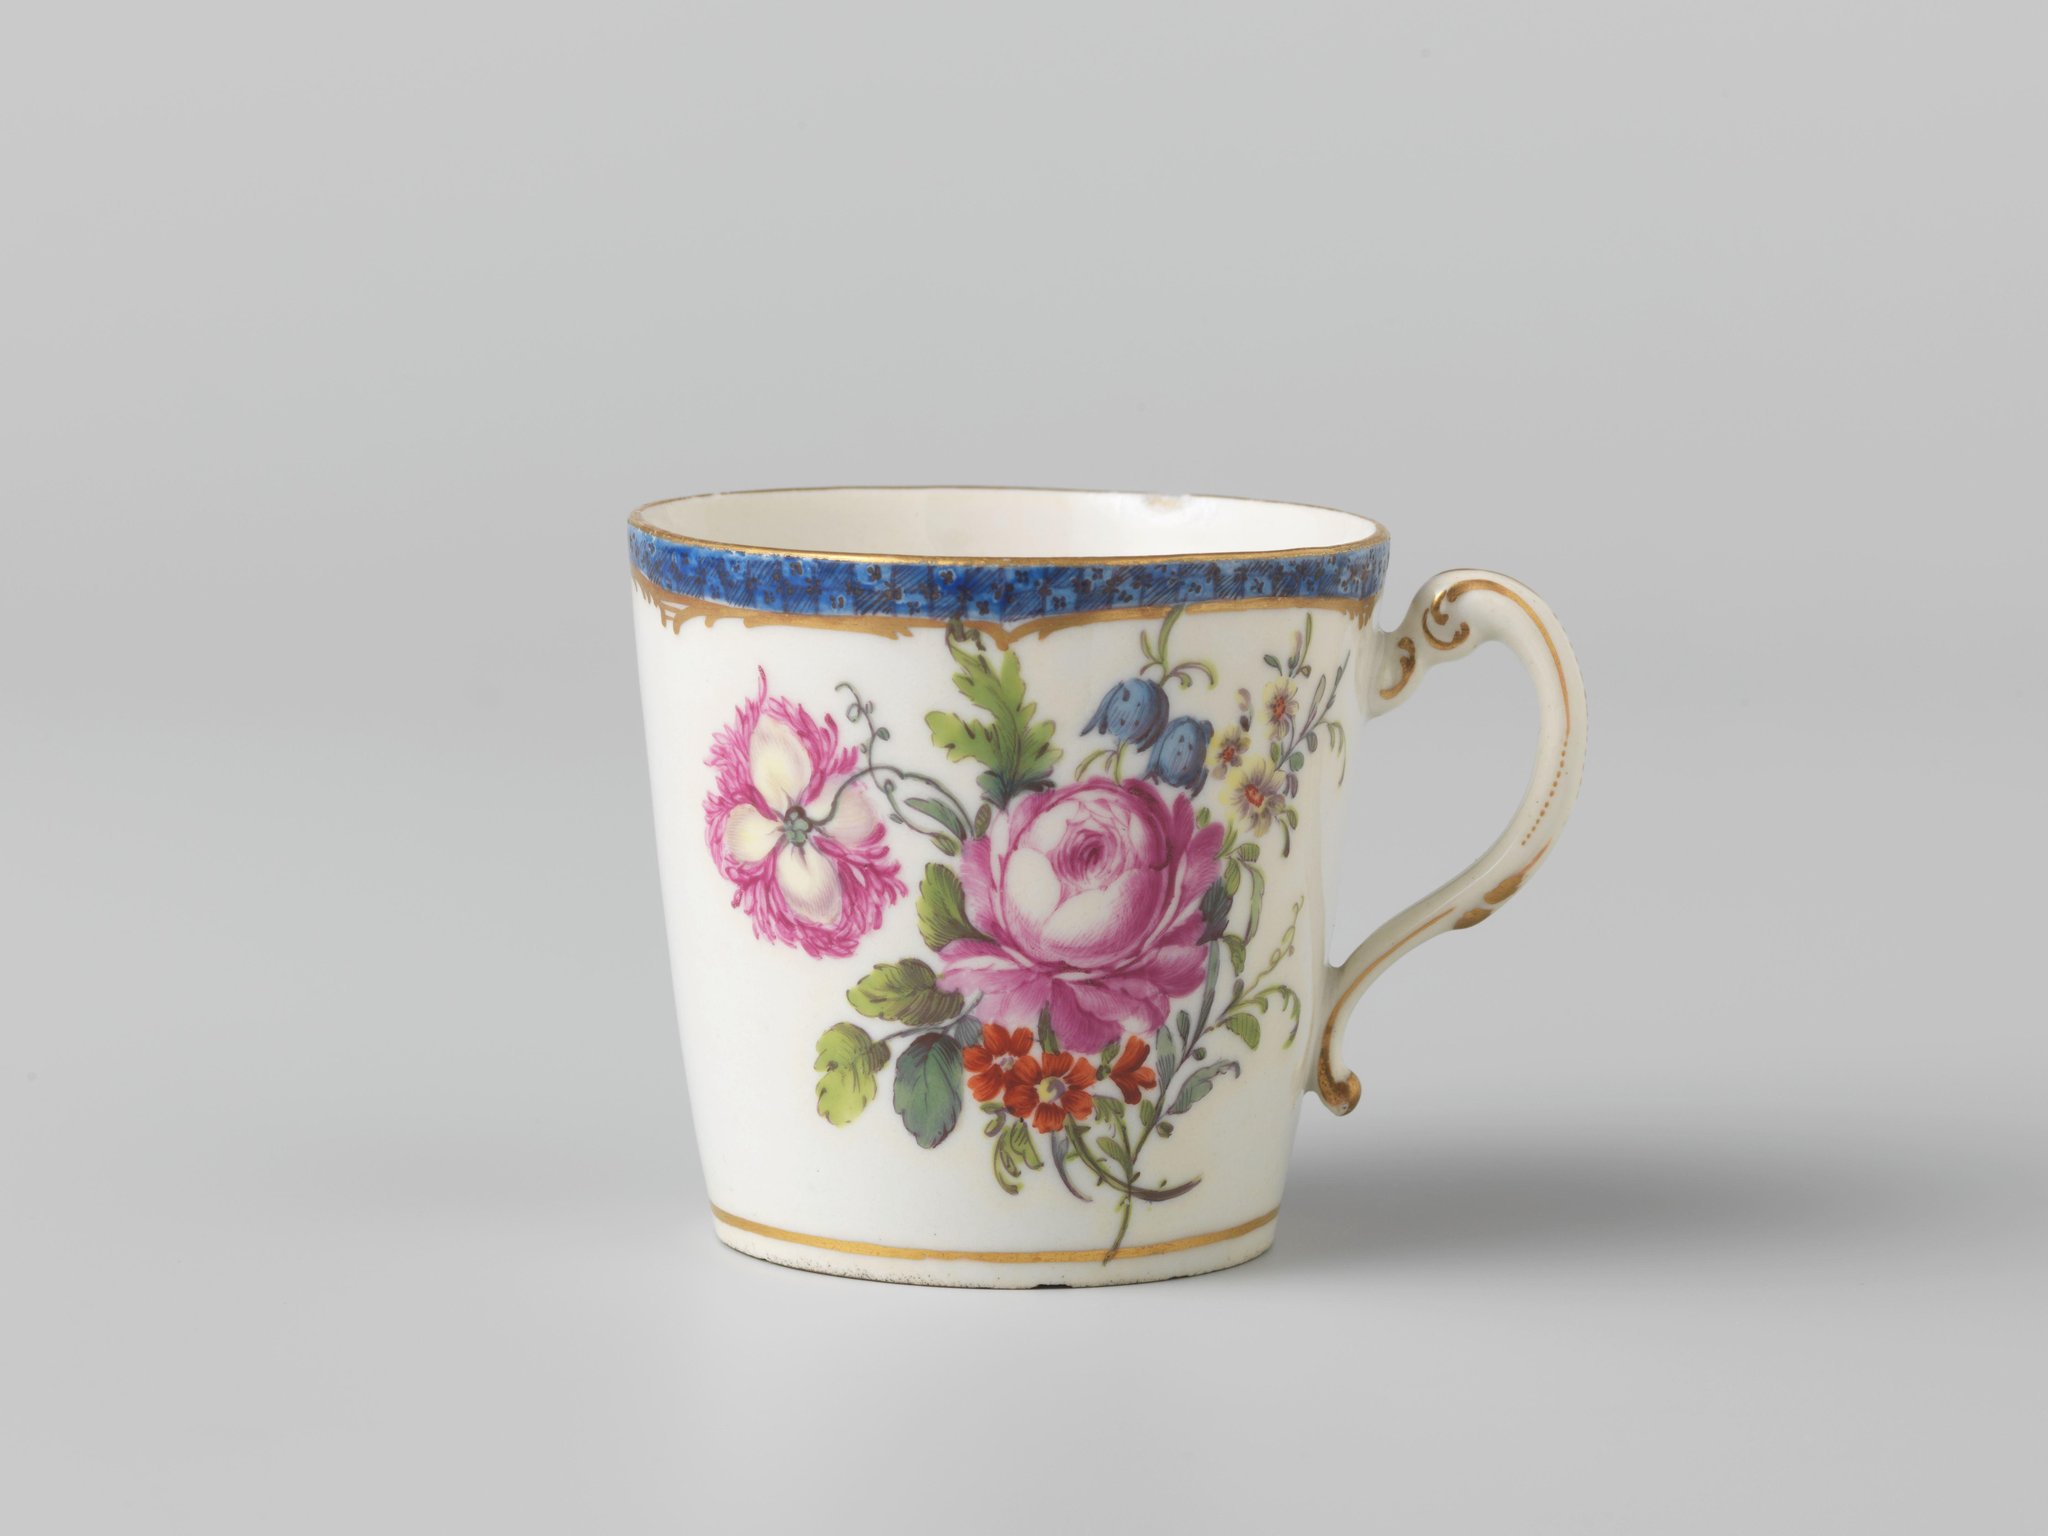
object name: cup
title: Kop, beschilderd met een bloemboeket en twee bloemtakken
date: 1778-1782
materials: porcelain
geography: loosdrecht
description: Coffee cup and saucer. Porcelain. Loosdrecht, c. 1778 - 1780. Factory of Joannes de Mol.